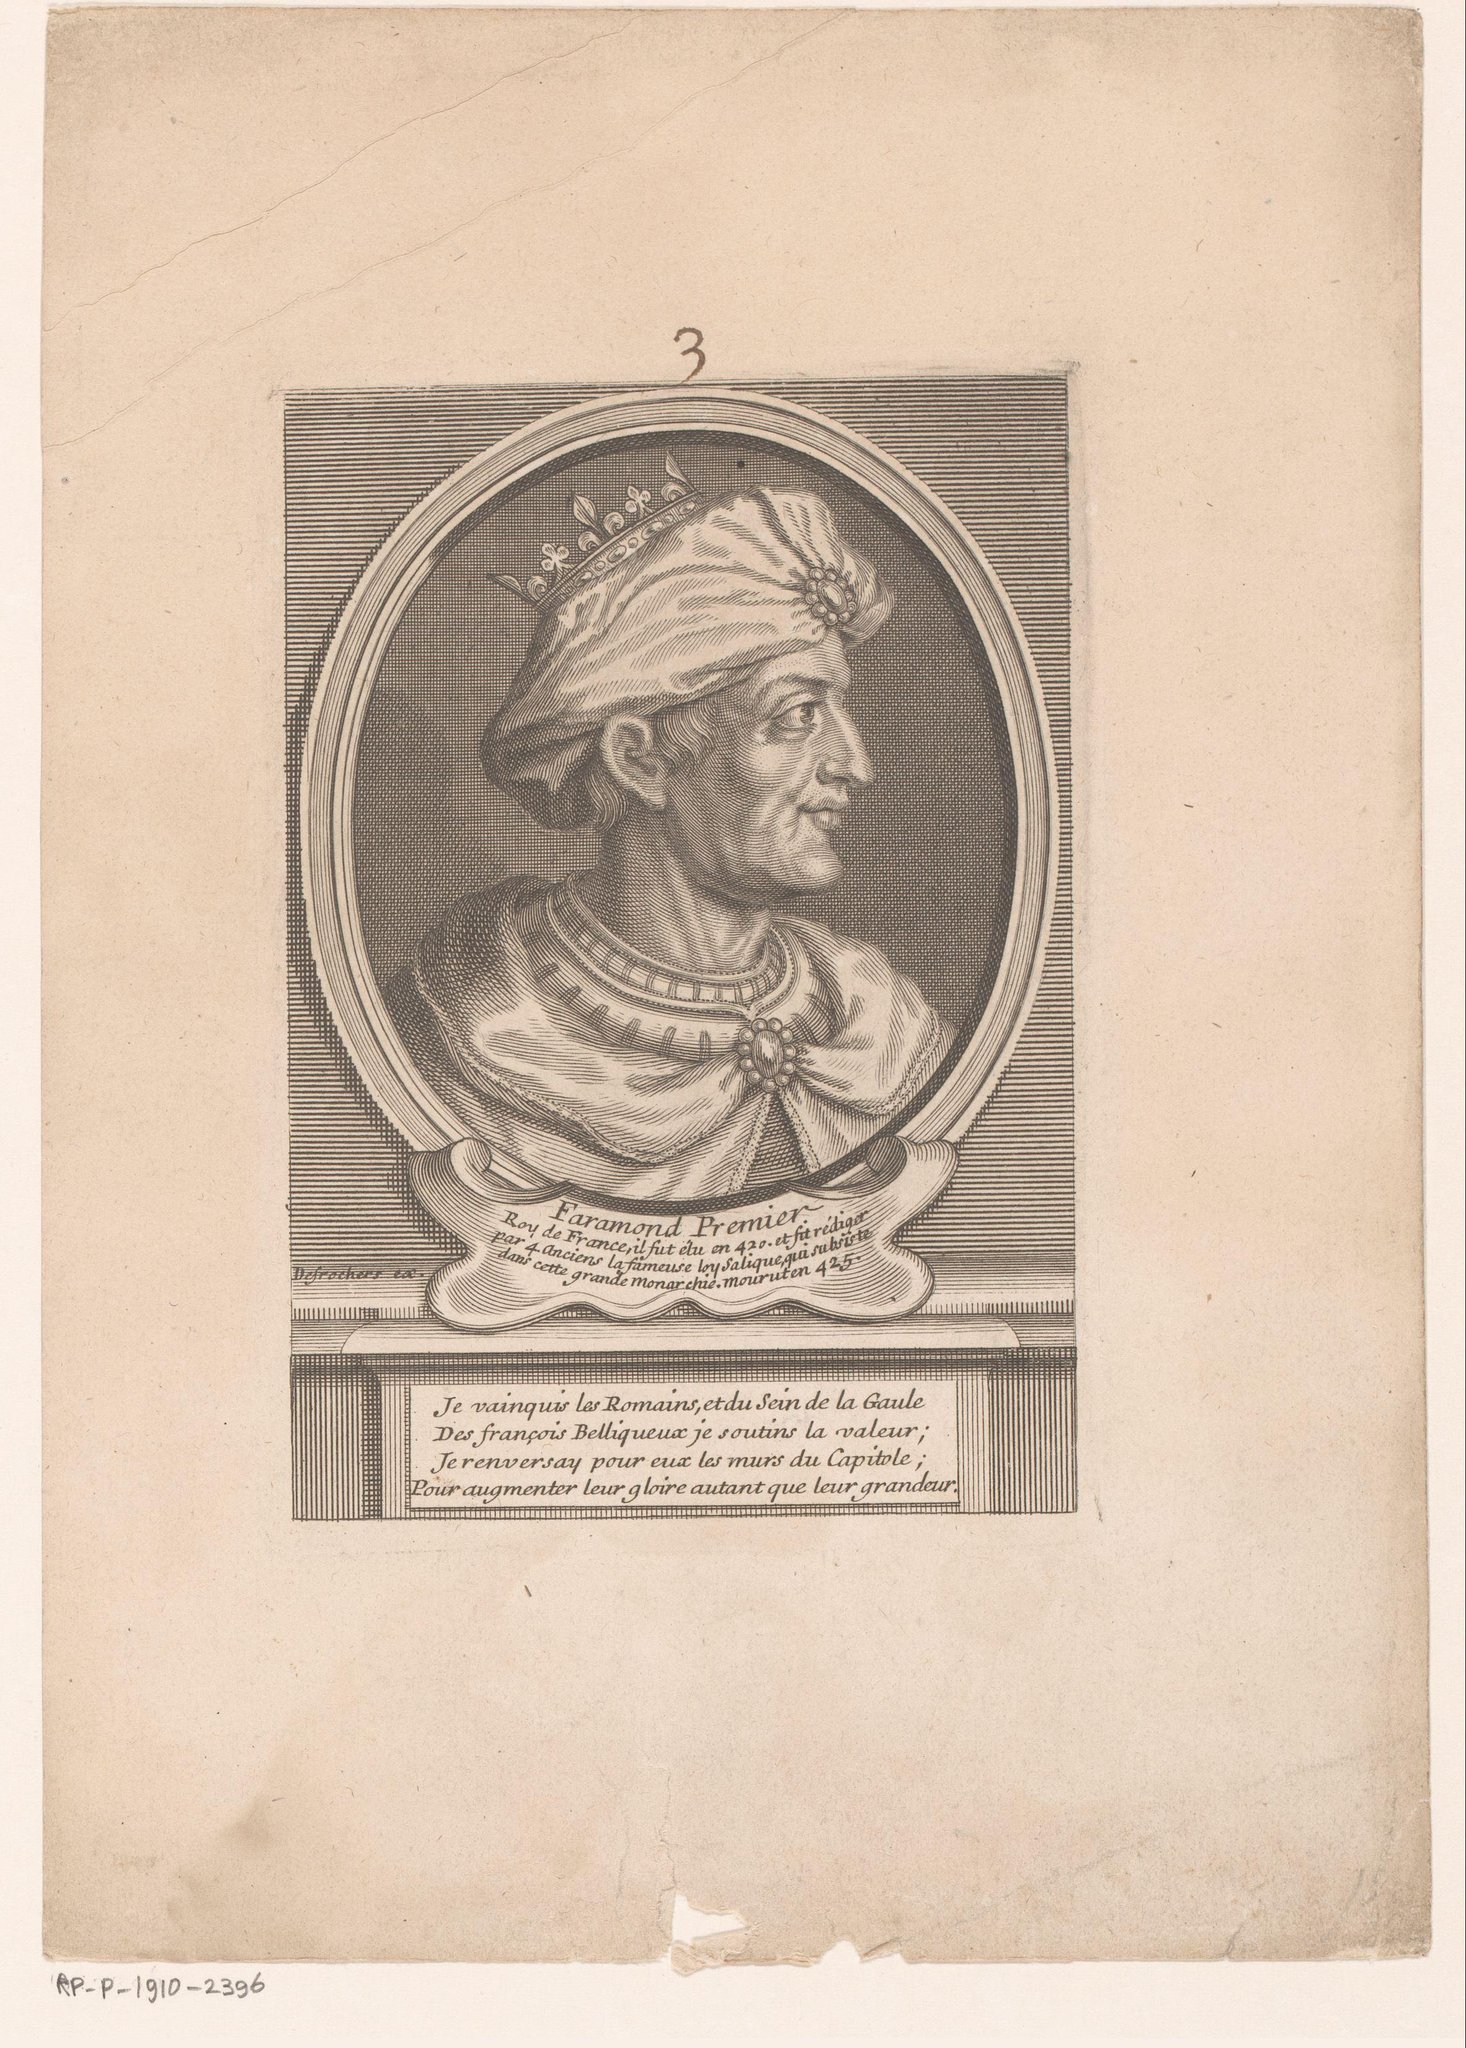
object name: print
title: Recueil de portraits (...)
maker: étienne desrochers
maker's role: print maker, publisher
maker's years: 1668-1741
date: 1726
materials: paper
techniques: engraving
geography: paris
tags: historical persons, king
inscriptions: number: ‘3’, collector's mark: Lugt 2228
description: Behoort waarschijnlijk tot een serie portretten, grotendeels door Etienne Desrochers, getiteld: 'Recueil de portraits de personnes qui se sont distinguées tant dans les Armes que dans Belles-Lettres et les Arts, comme aussi la famille royale de France et autres cours étrangères'. De serie werd initieel uitgegeven door Desrochers en aangekondigd in 'Mercure' in mei 1726, p. 985. Echter was Desrochers reeds enkele jaren eerder begonnen met het uitgeven van de serie. Na de dood van Desrochers werd de serie voortgezet door Gilles Edme Petit. Een latere staat werd uitgegeven door Jean François Daumont in Parijs.